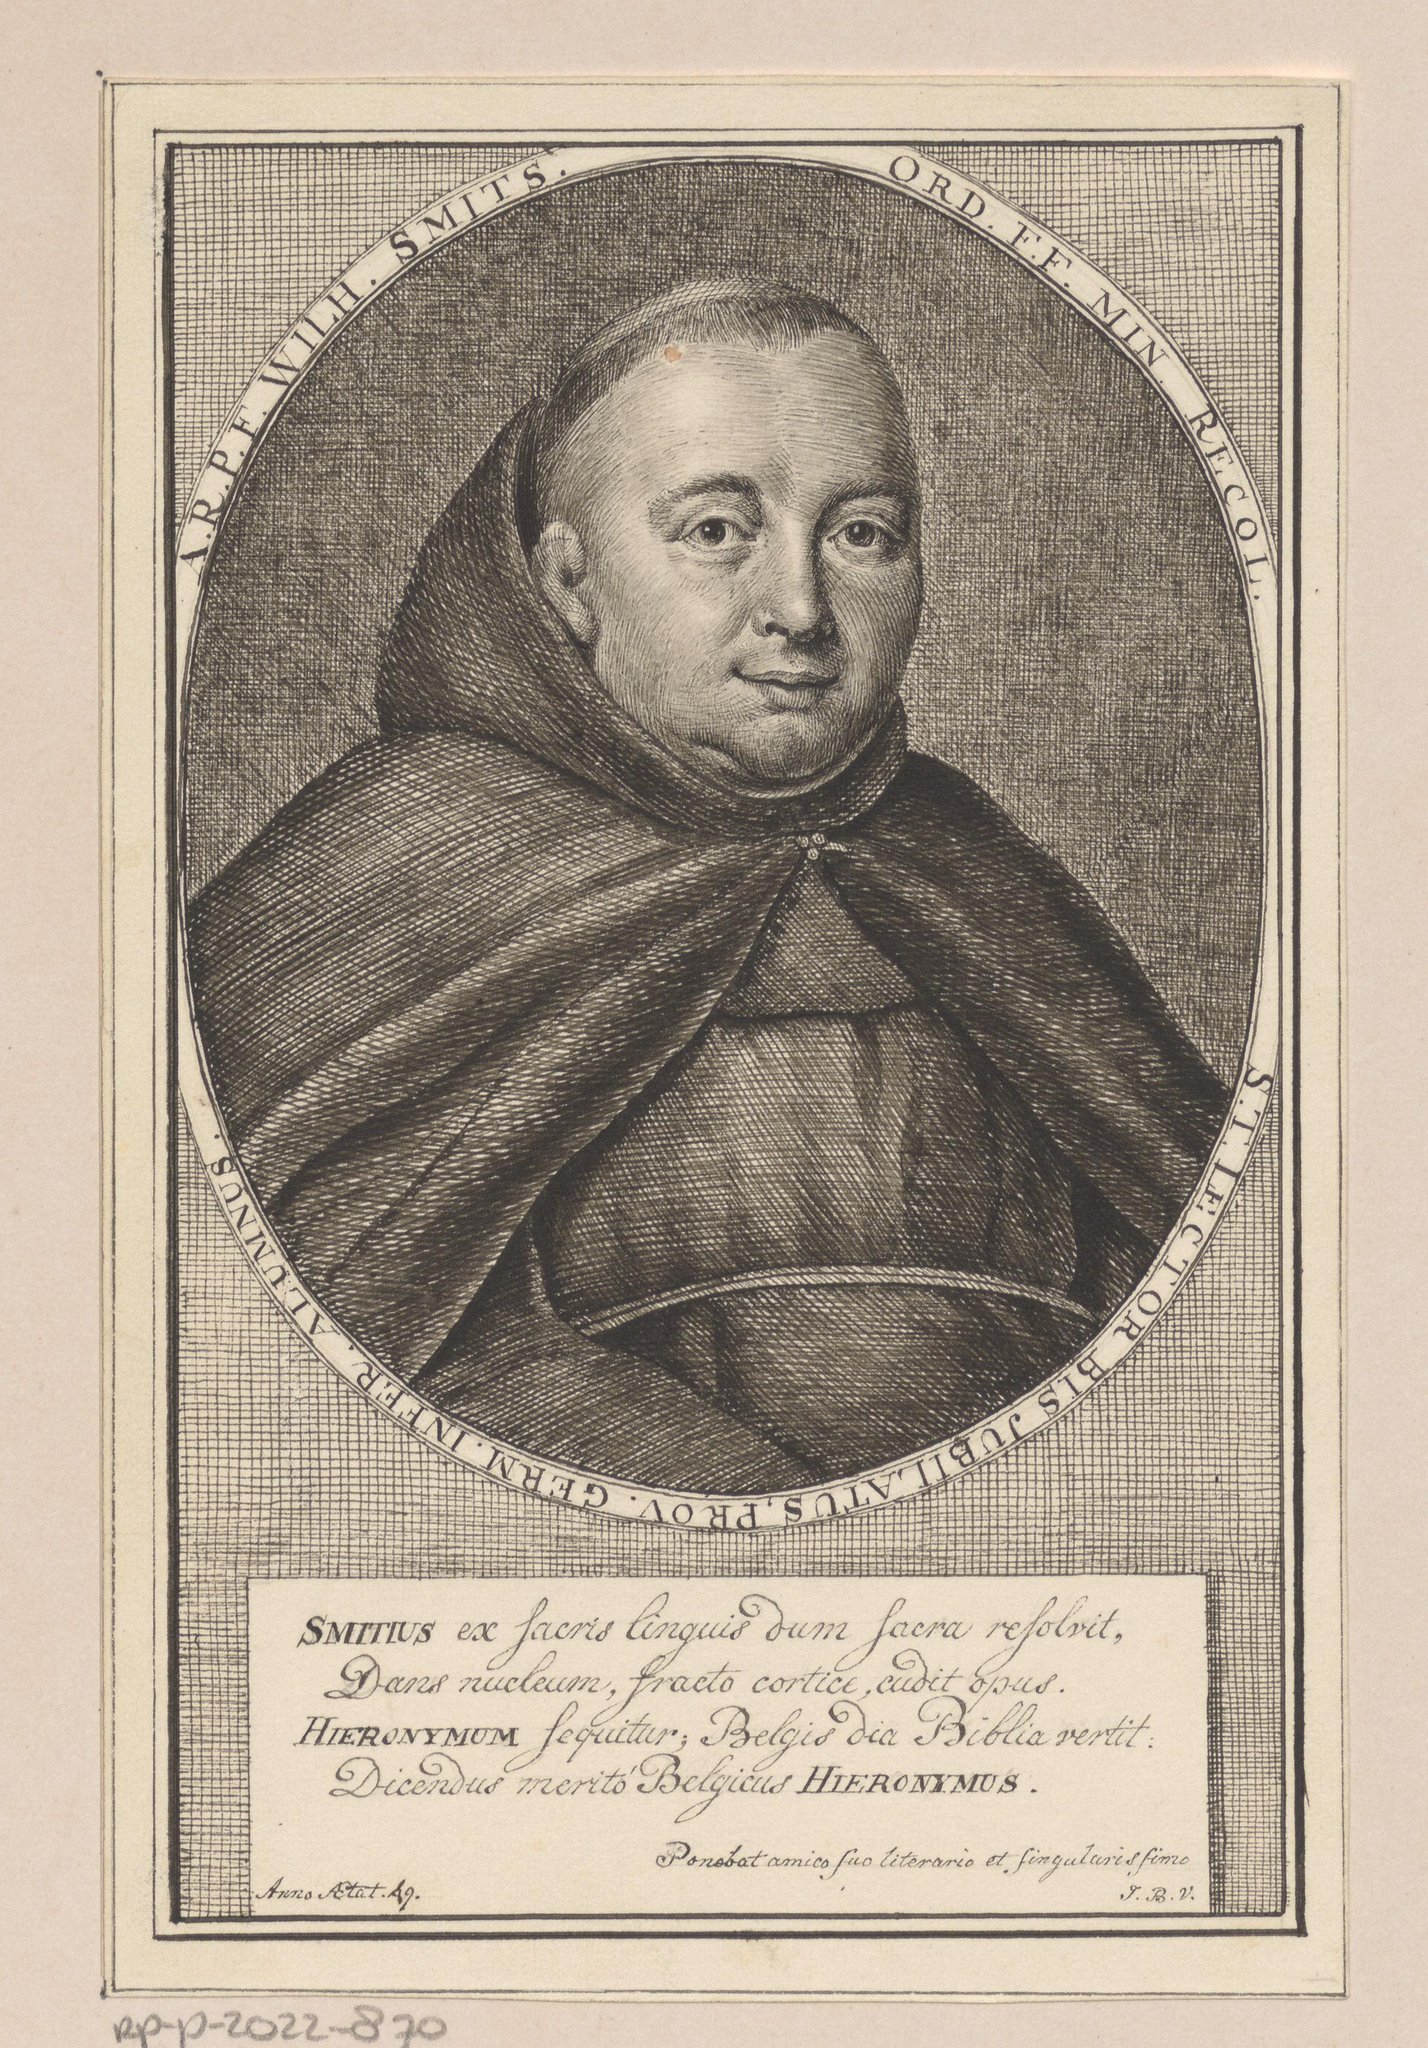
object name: drawing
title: Portret van Willem Smits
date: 1753-1799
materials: ink, paper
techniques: brush, pen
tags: historical persons, monk(s), friar(s)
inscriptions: inscription: ‘n.omstr 1700 (...) J.C. / Wendel’, collector's mark: Lugt 2228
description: Met vierregelig onderschrift in het Latijn en tekst in het Latijn rondom het portret.